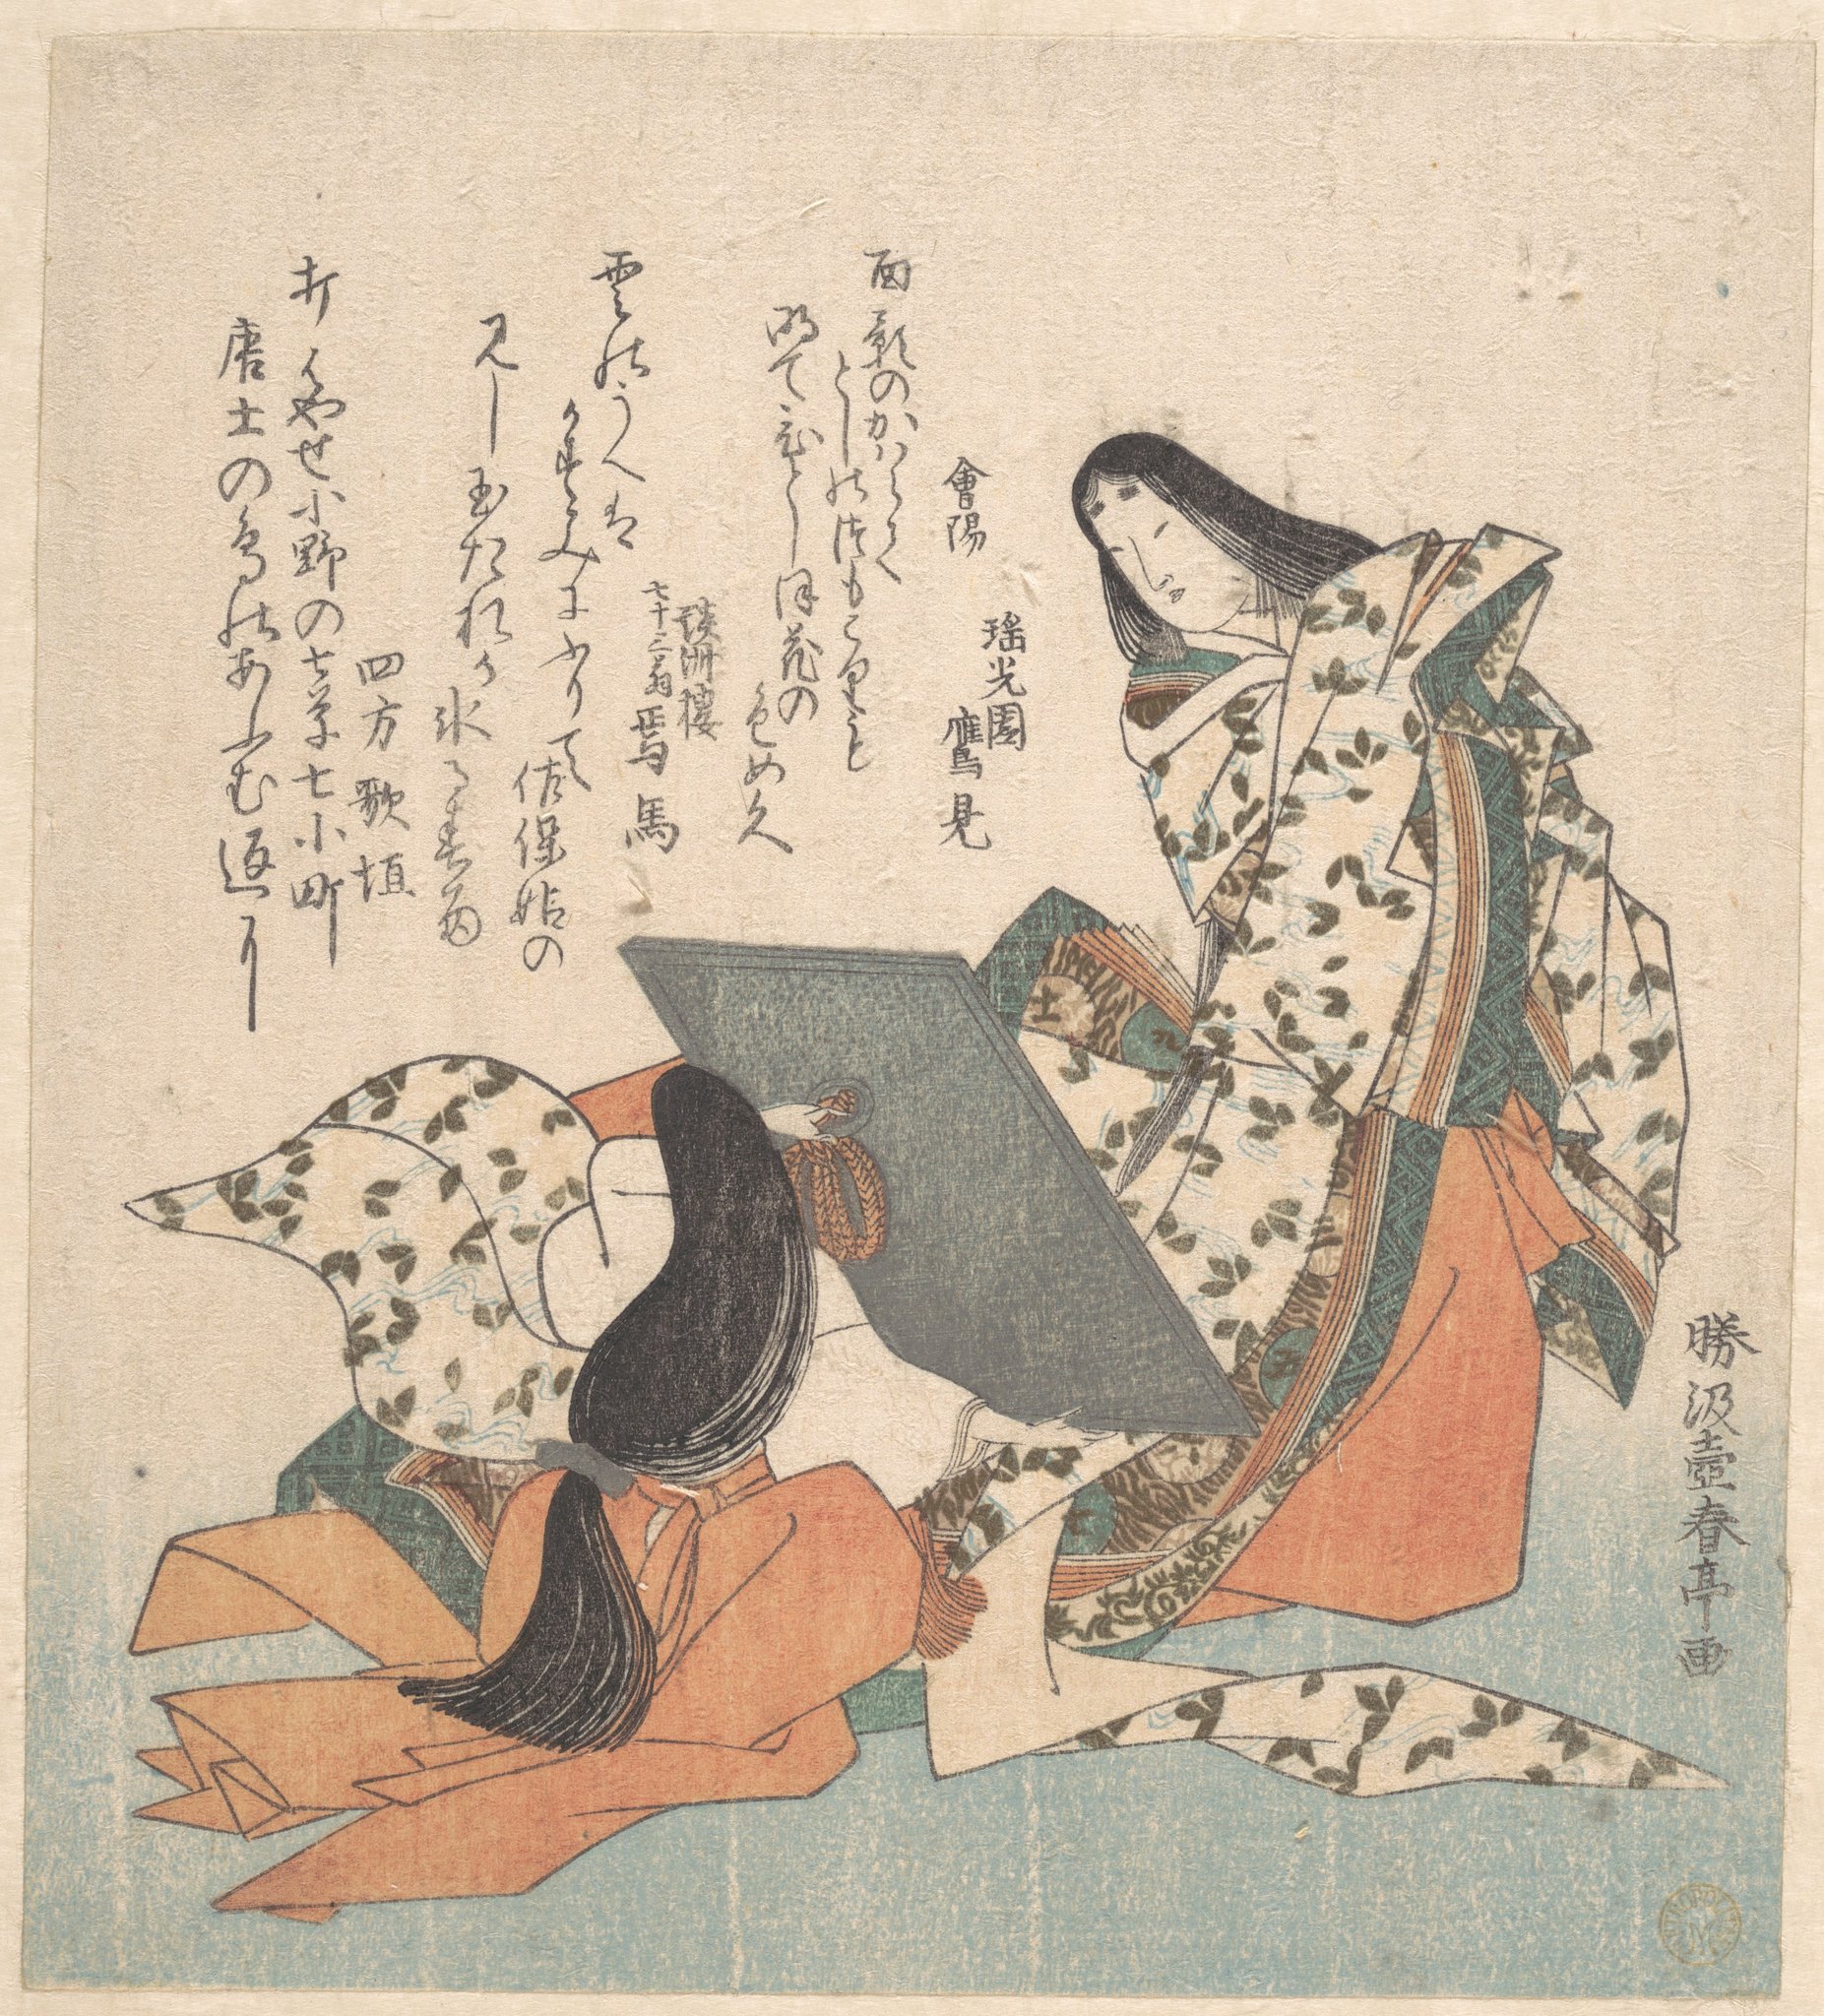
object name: print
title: Ono-no-Komachi Looking at Her Reflection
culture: japanese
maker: katsukawa shuntei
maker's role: artist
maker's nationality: japanese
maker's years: 1770-1820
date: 1815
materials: ink, paper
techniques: surimono, woodblock print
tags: women